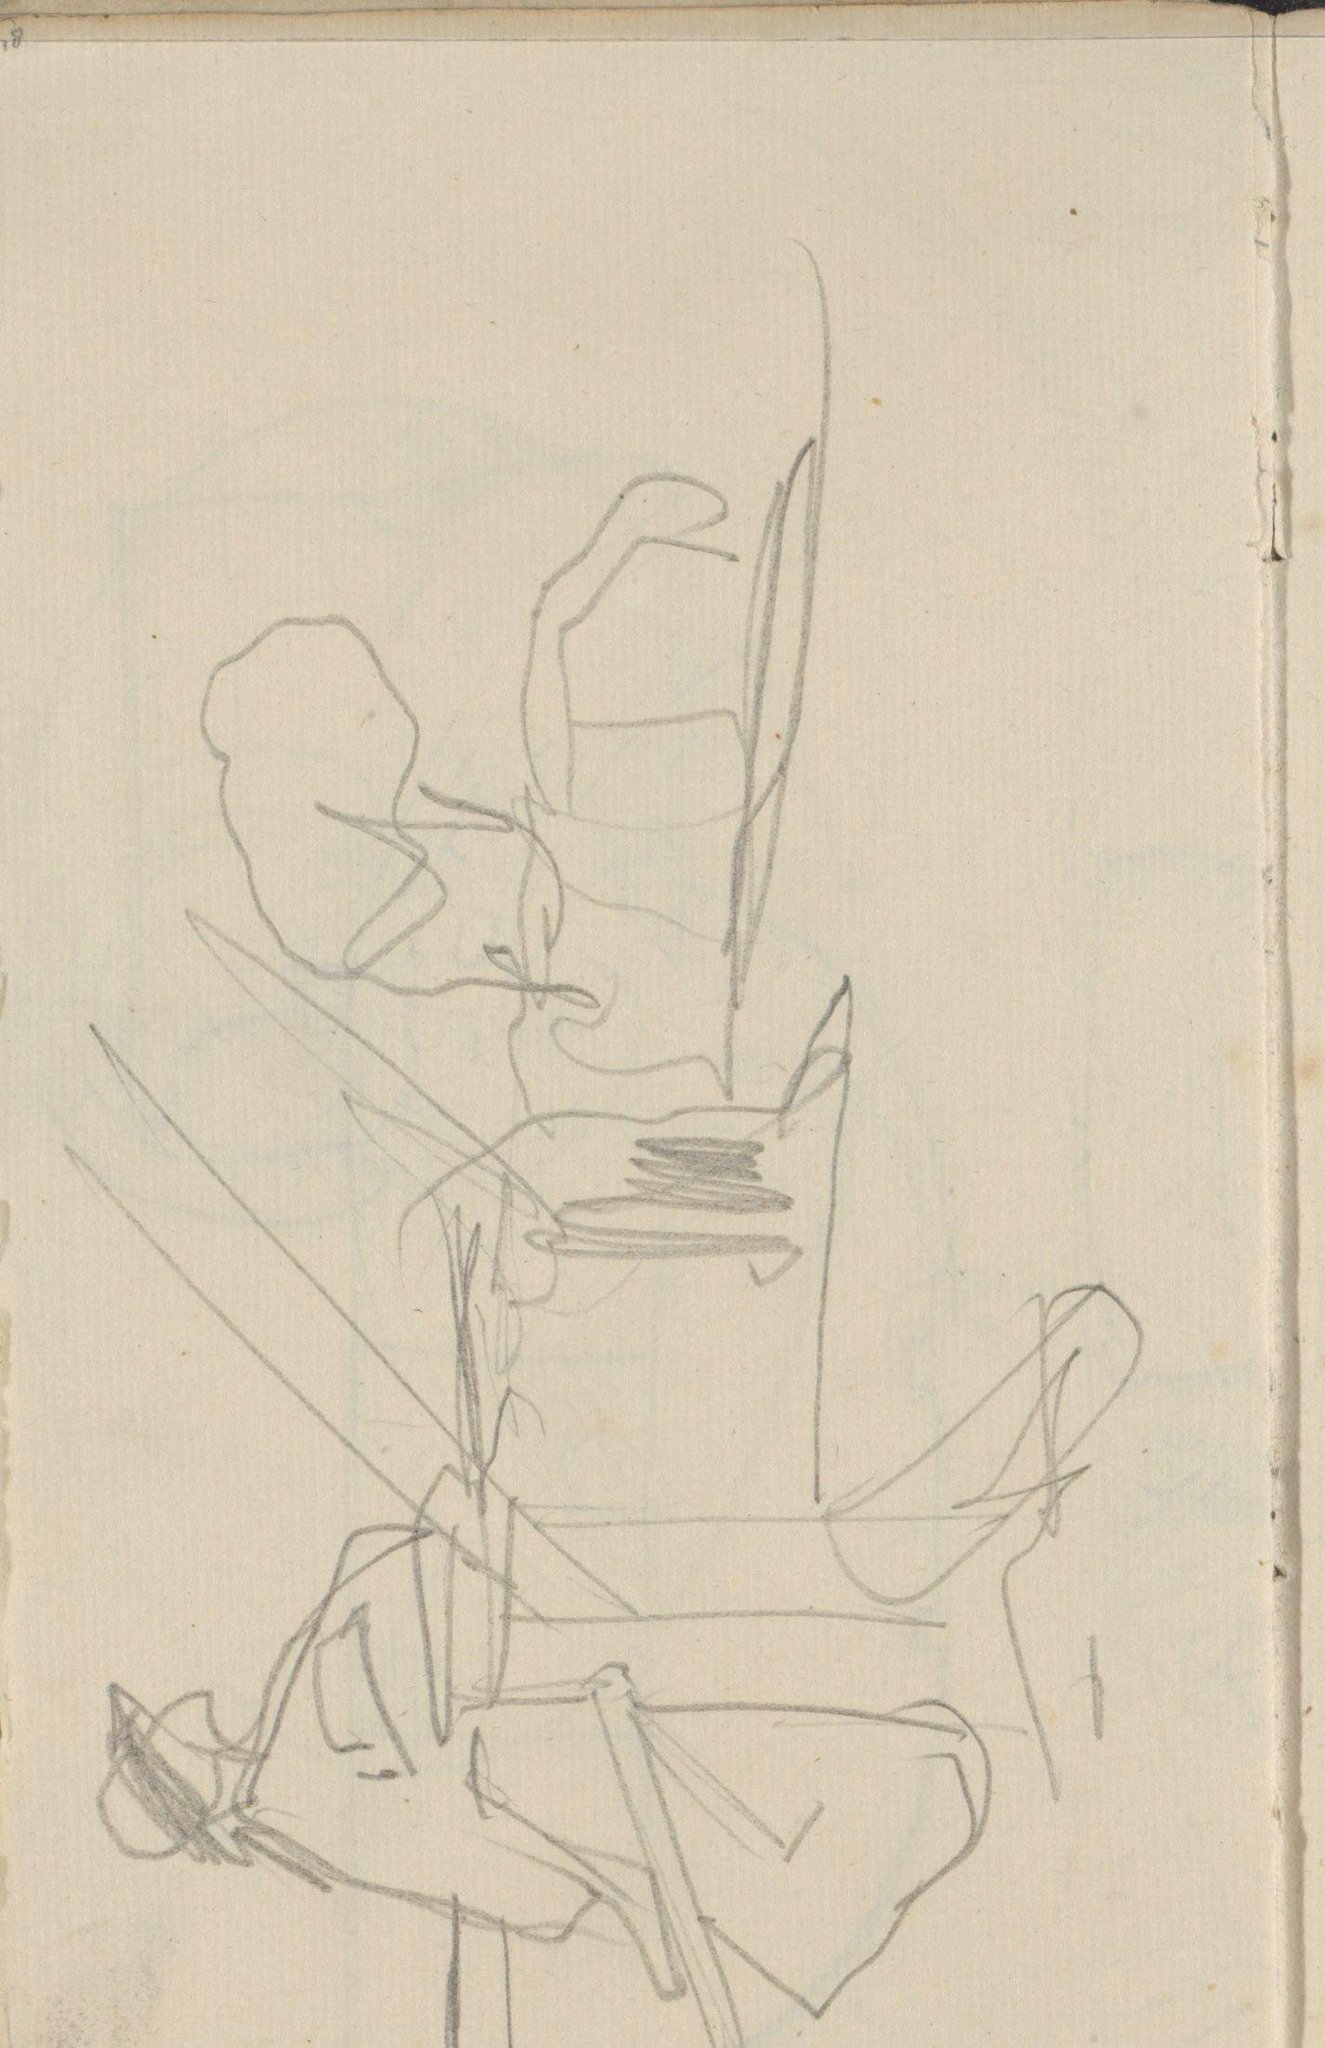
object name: sketchbook leaf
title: Vrouw, mogelijk op een brug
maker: george hendrik breitner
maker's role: draughtsman, painter, print maker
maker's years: 1857-1923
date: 1880-1882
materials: paper, pencil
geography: the hague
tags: adult woman, bridge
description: Pagina 18 uit een schetsboek met 25 bladen.